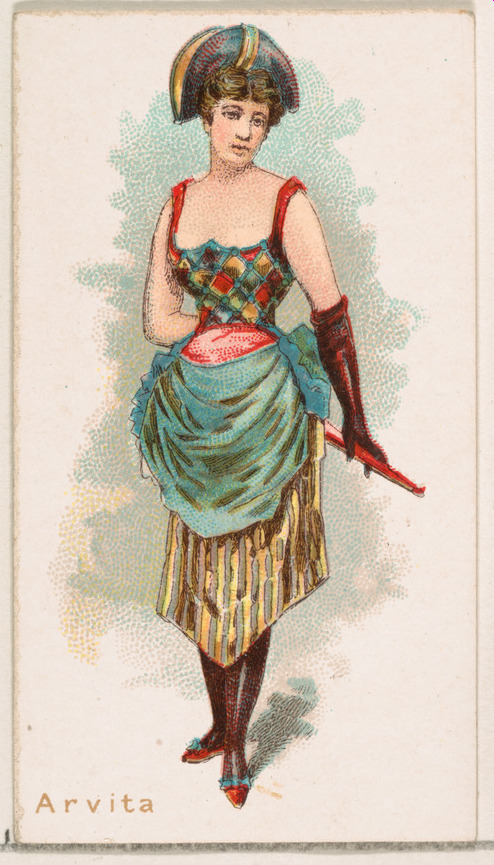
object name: print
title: Arvita, from the Ballet Queens series (N182) issued by Wm. S. Kimball & Co.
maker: william s. kimball & company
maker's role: publisher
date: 1889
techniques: color lithograph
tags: women,dancing,dancers